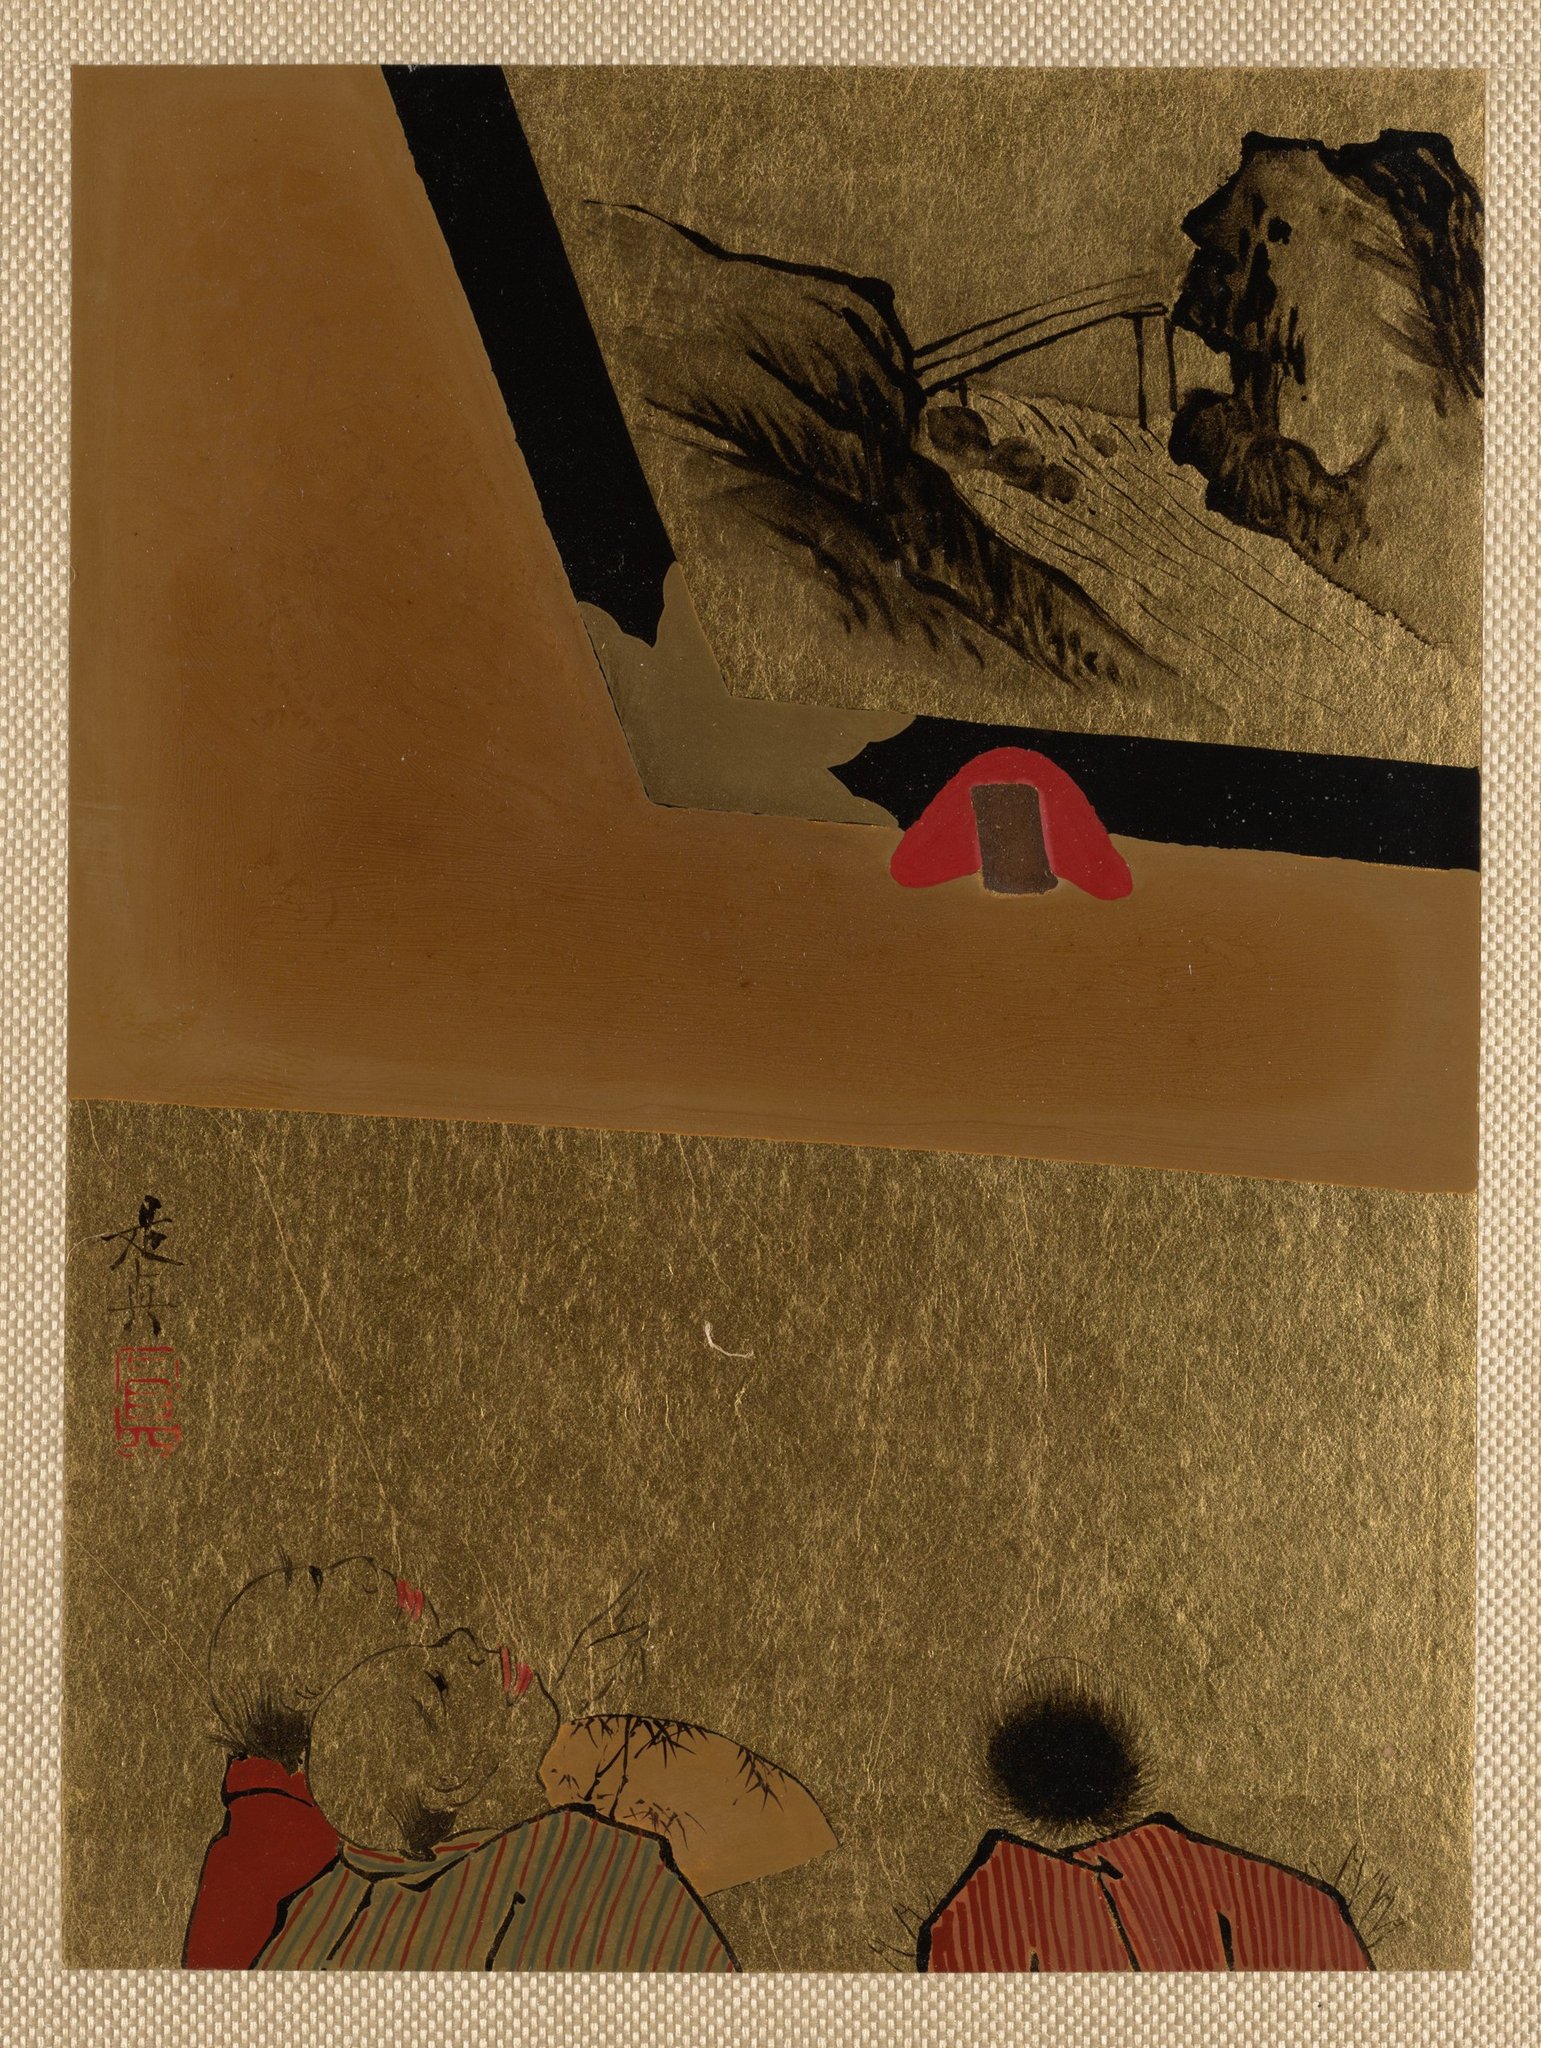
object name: album leaf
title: Three Men Looking at Framed Lacquer Drawing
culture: japanese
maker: shibata zeshin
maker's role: artist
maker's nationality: japanese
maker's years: 1807-1891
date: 1807-1868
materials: gold, lacquer, paper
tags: men